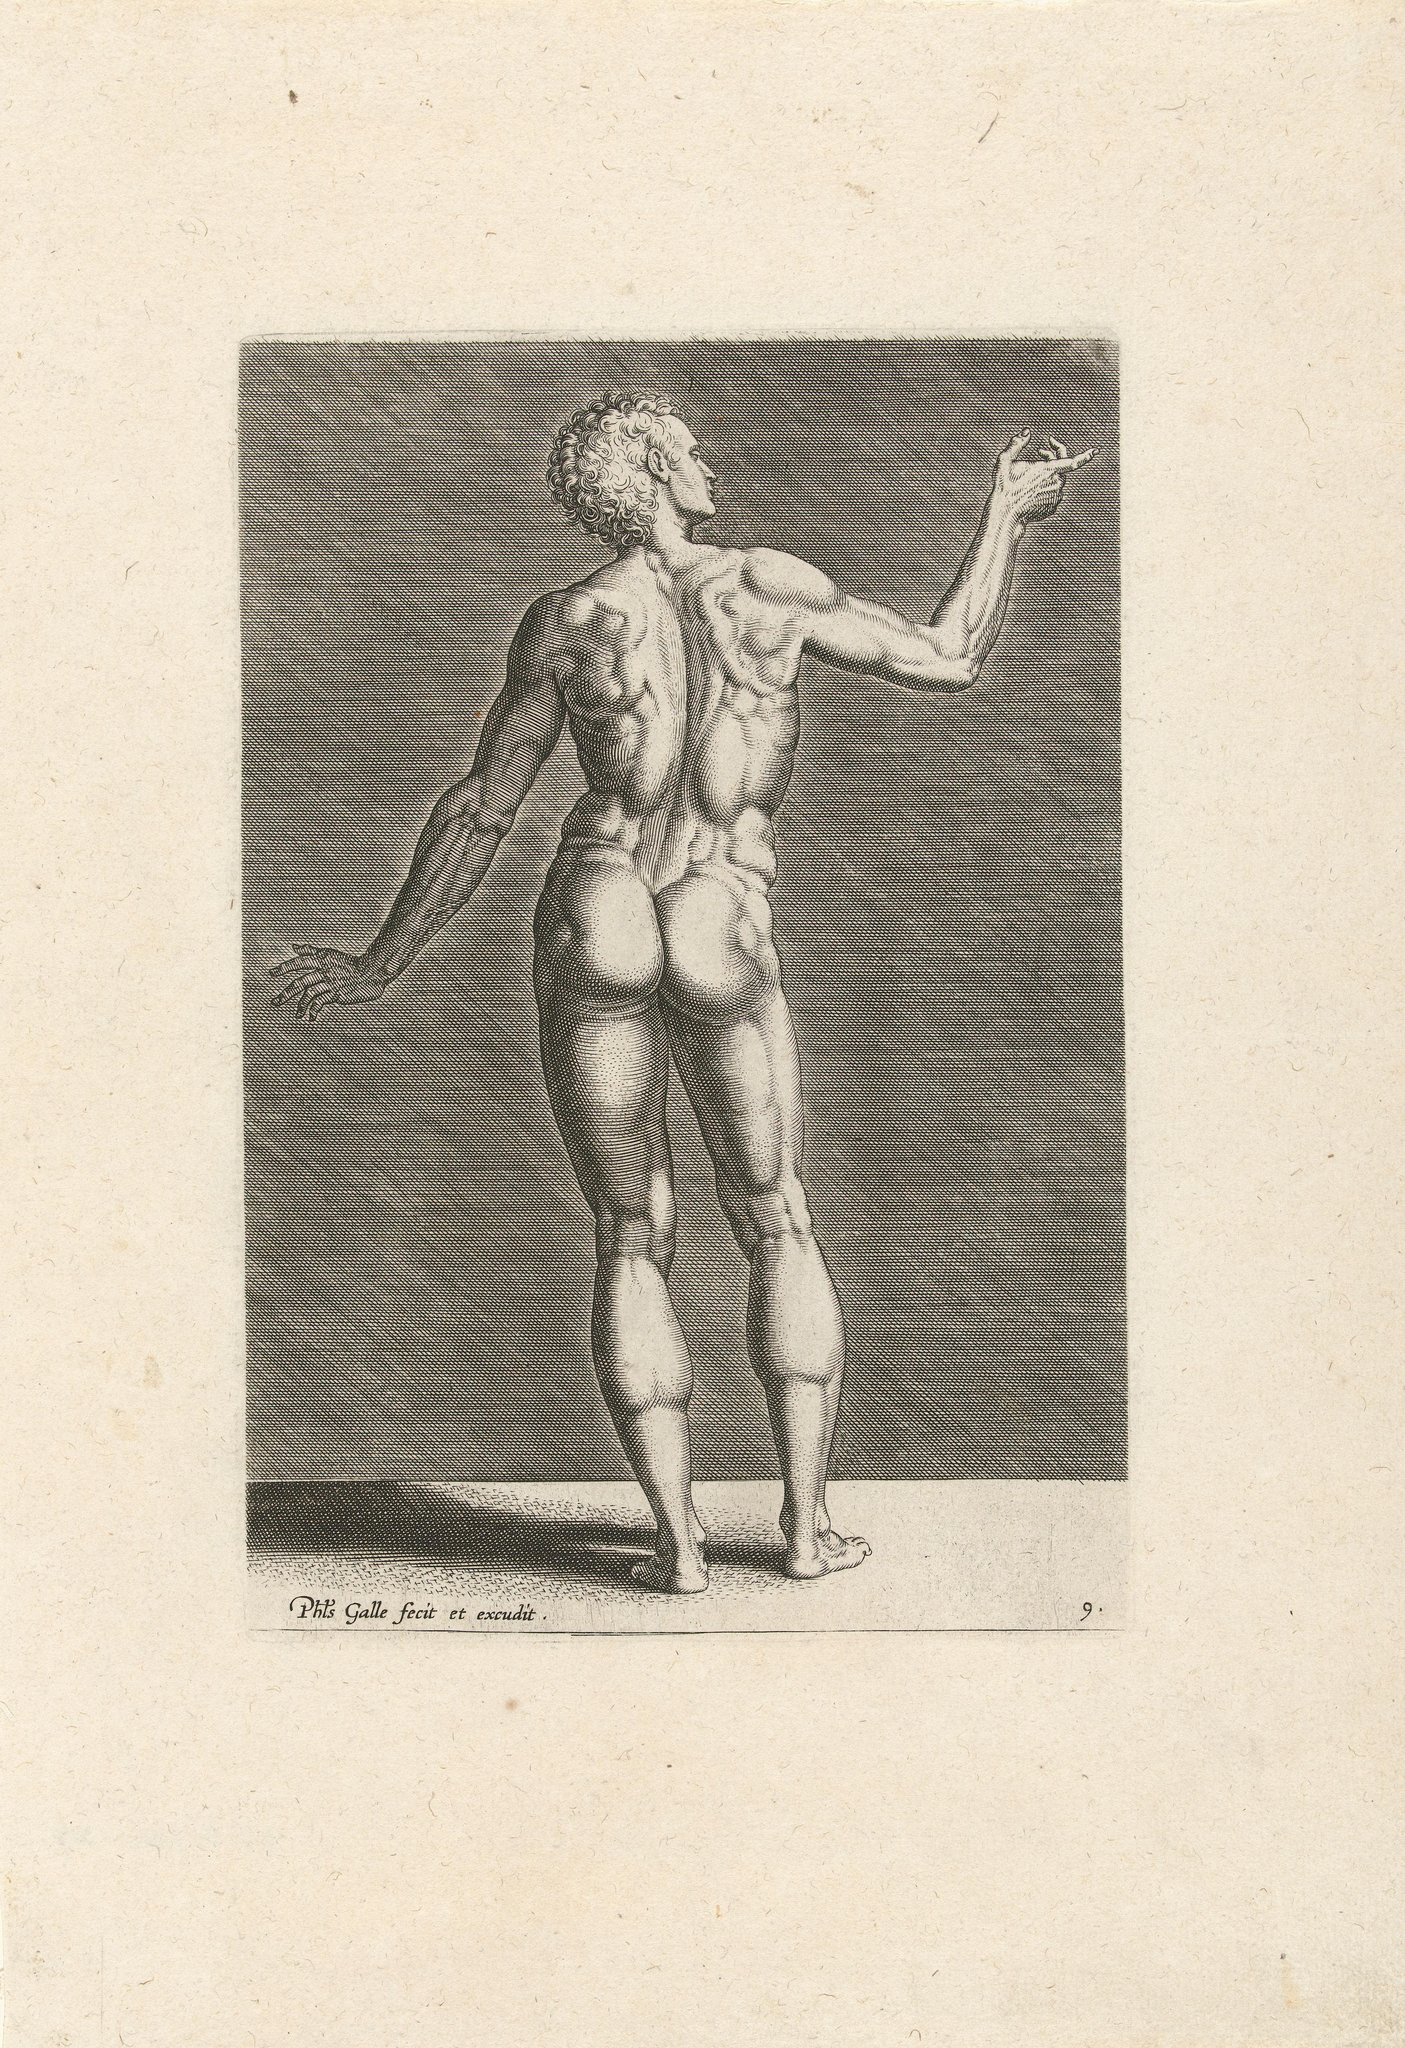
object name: print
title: Instructions et fondements de bien pourtraire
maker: philips galle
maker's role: print maker, publisher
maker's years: 1537-1612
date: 1589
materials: paper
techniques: engraving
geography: antwerp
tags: standing figure, anatomy (non-medical)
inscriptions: collector's mark: Lugt 2760, watermark: ‘Hand’ Briquet II 137, collector's mark: Lugt 2228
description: Naakte mannenfiguur, op de rug gezien. De prent maakt deel uit van een dertiendelige serie over de fundamenten van het tekenen.